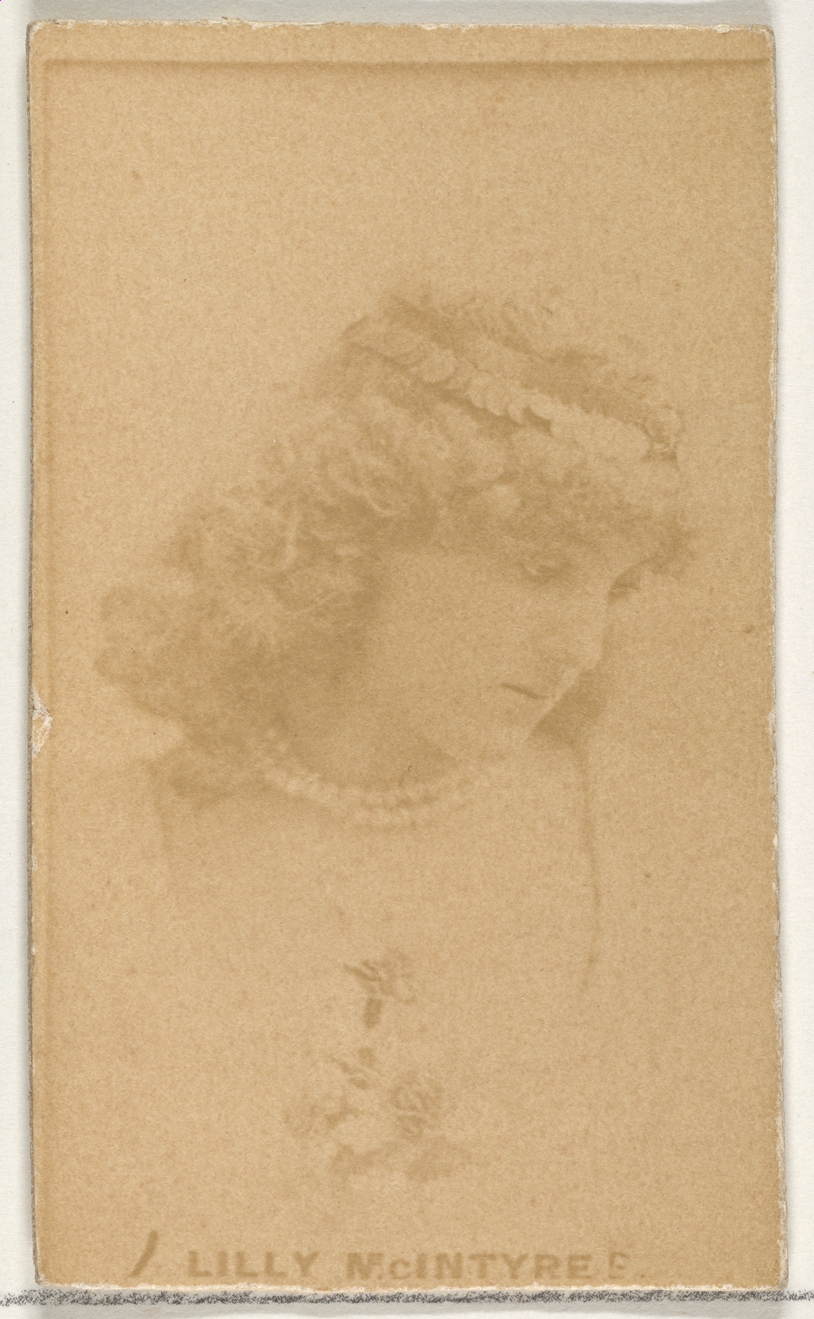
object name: photograph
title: Lilly McIntyre, from the Actors and Actresses series (N45, Type 1) for Virginia Brights Cigarettes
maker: allen & ginter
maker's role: publisher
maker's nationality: american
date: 1888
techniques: albumen silver print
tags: portraits,women,actresses